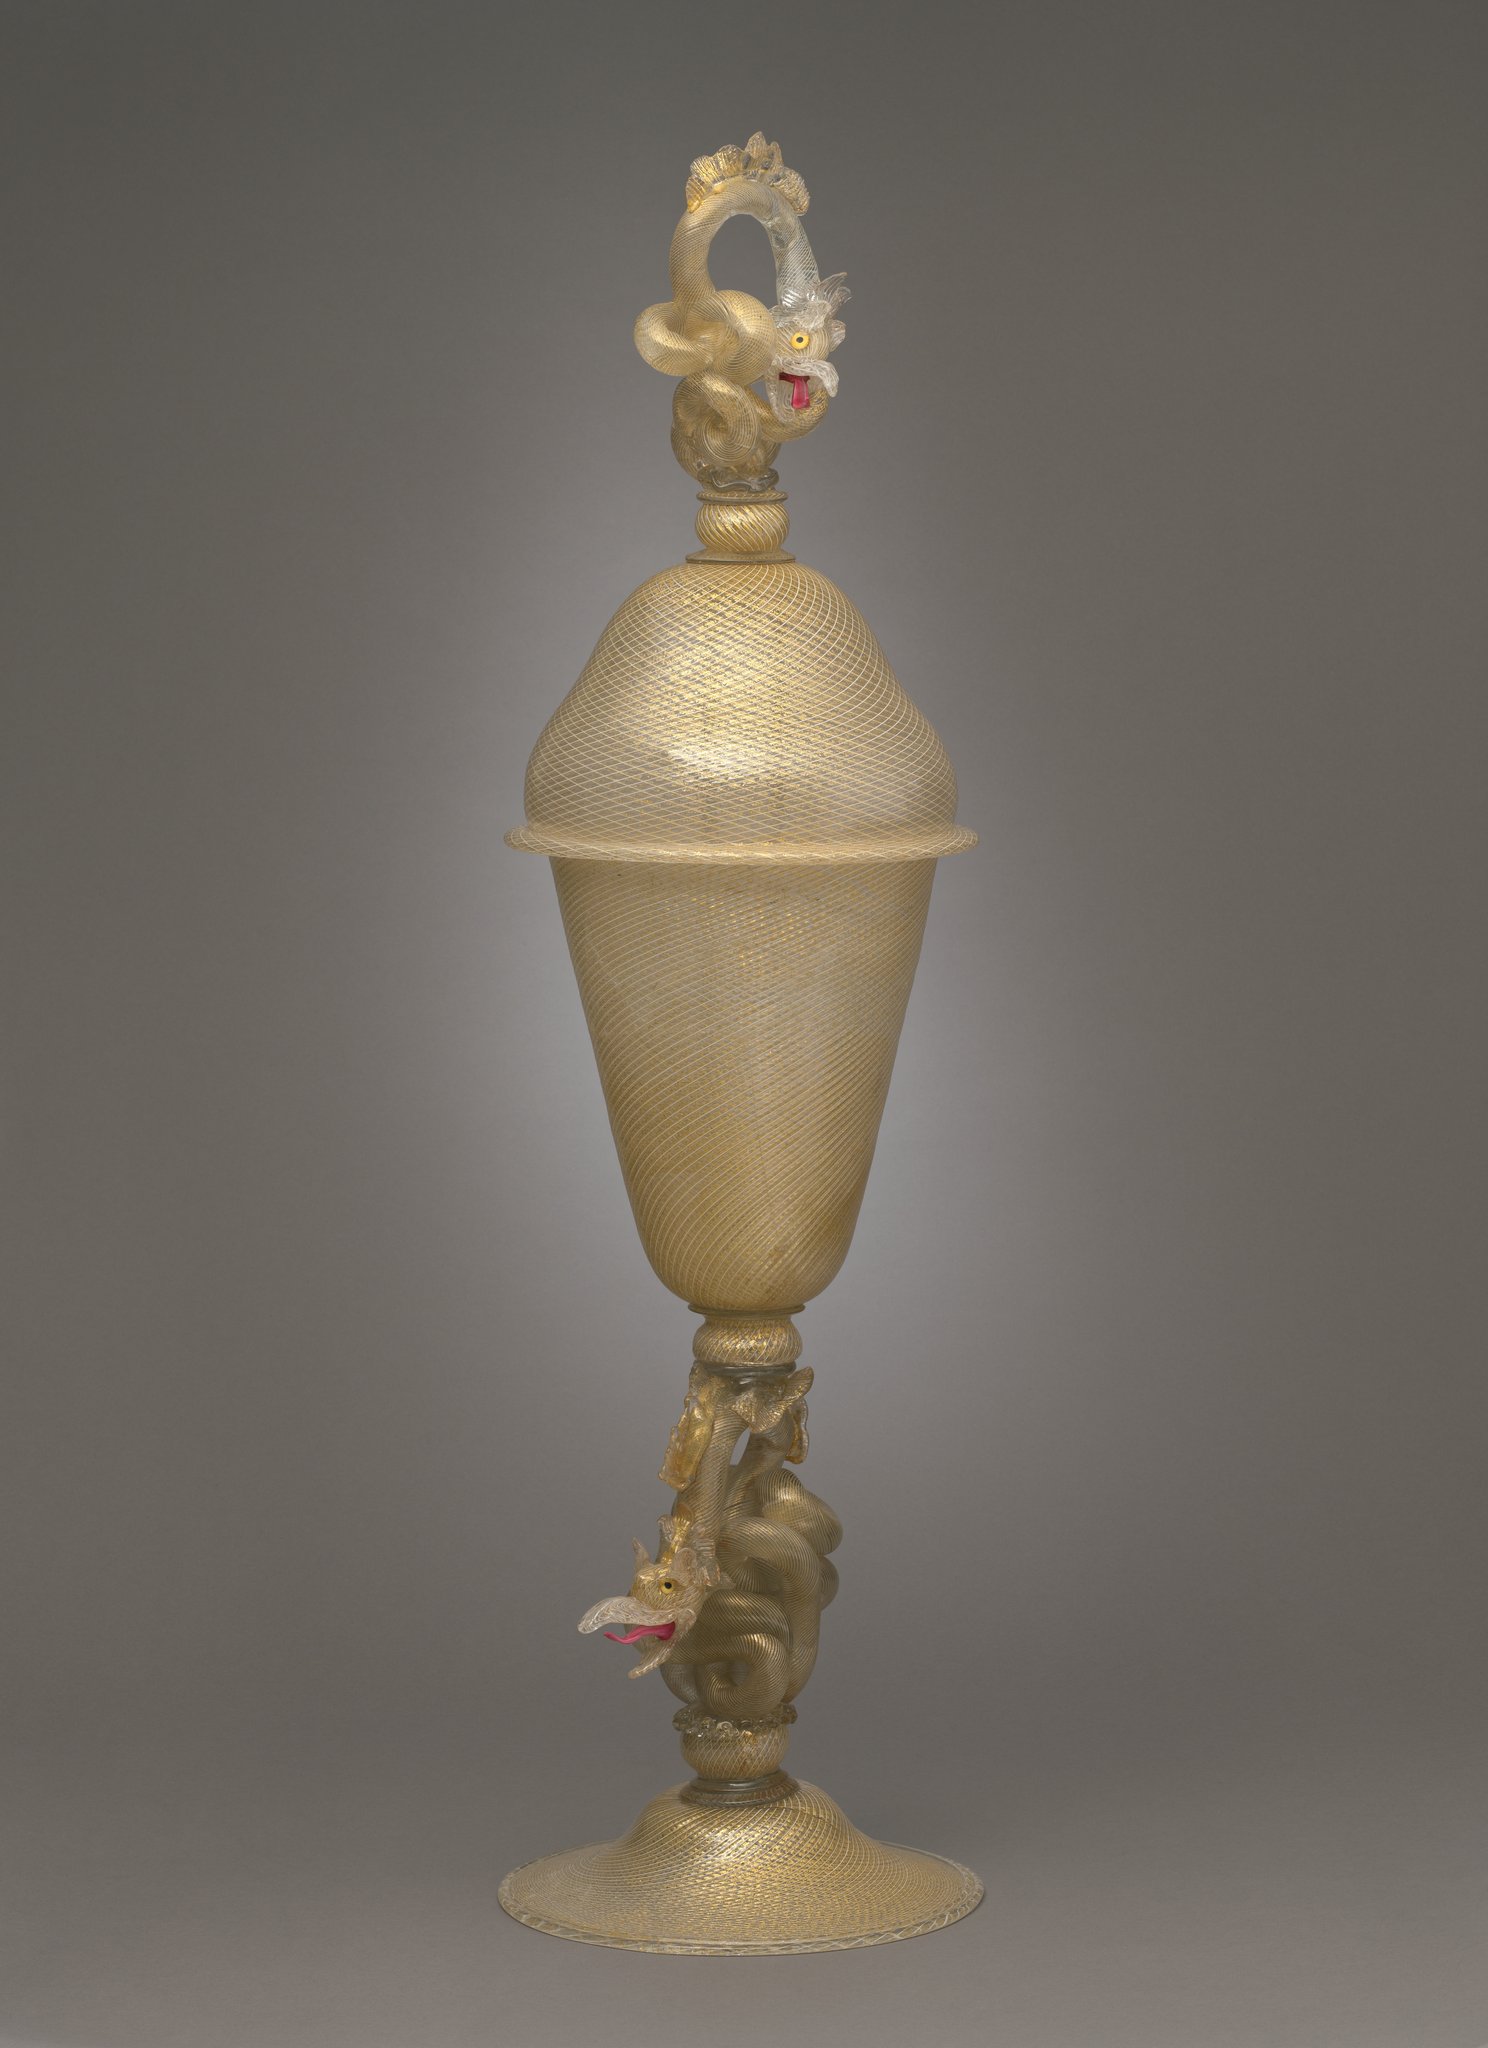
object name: covered goblet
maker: salviati and co.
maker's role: maker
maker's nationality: italian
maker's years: 1859-1987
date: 1866-1880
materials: glass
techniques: gilding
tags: serpents